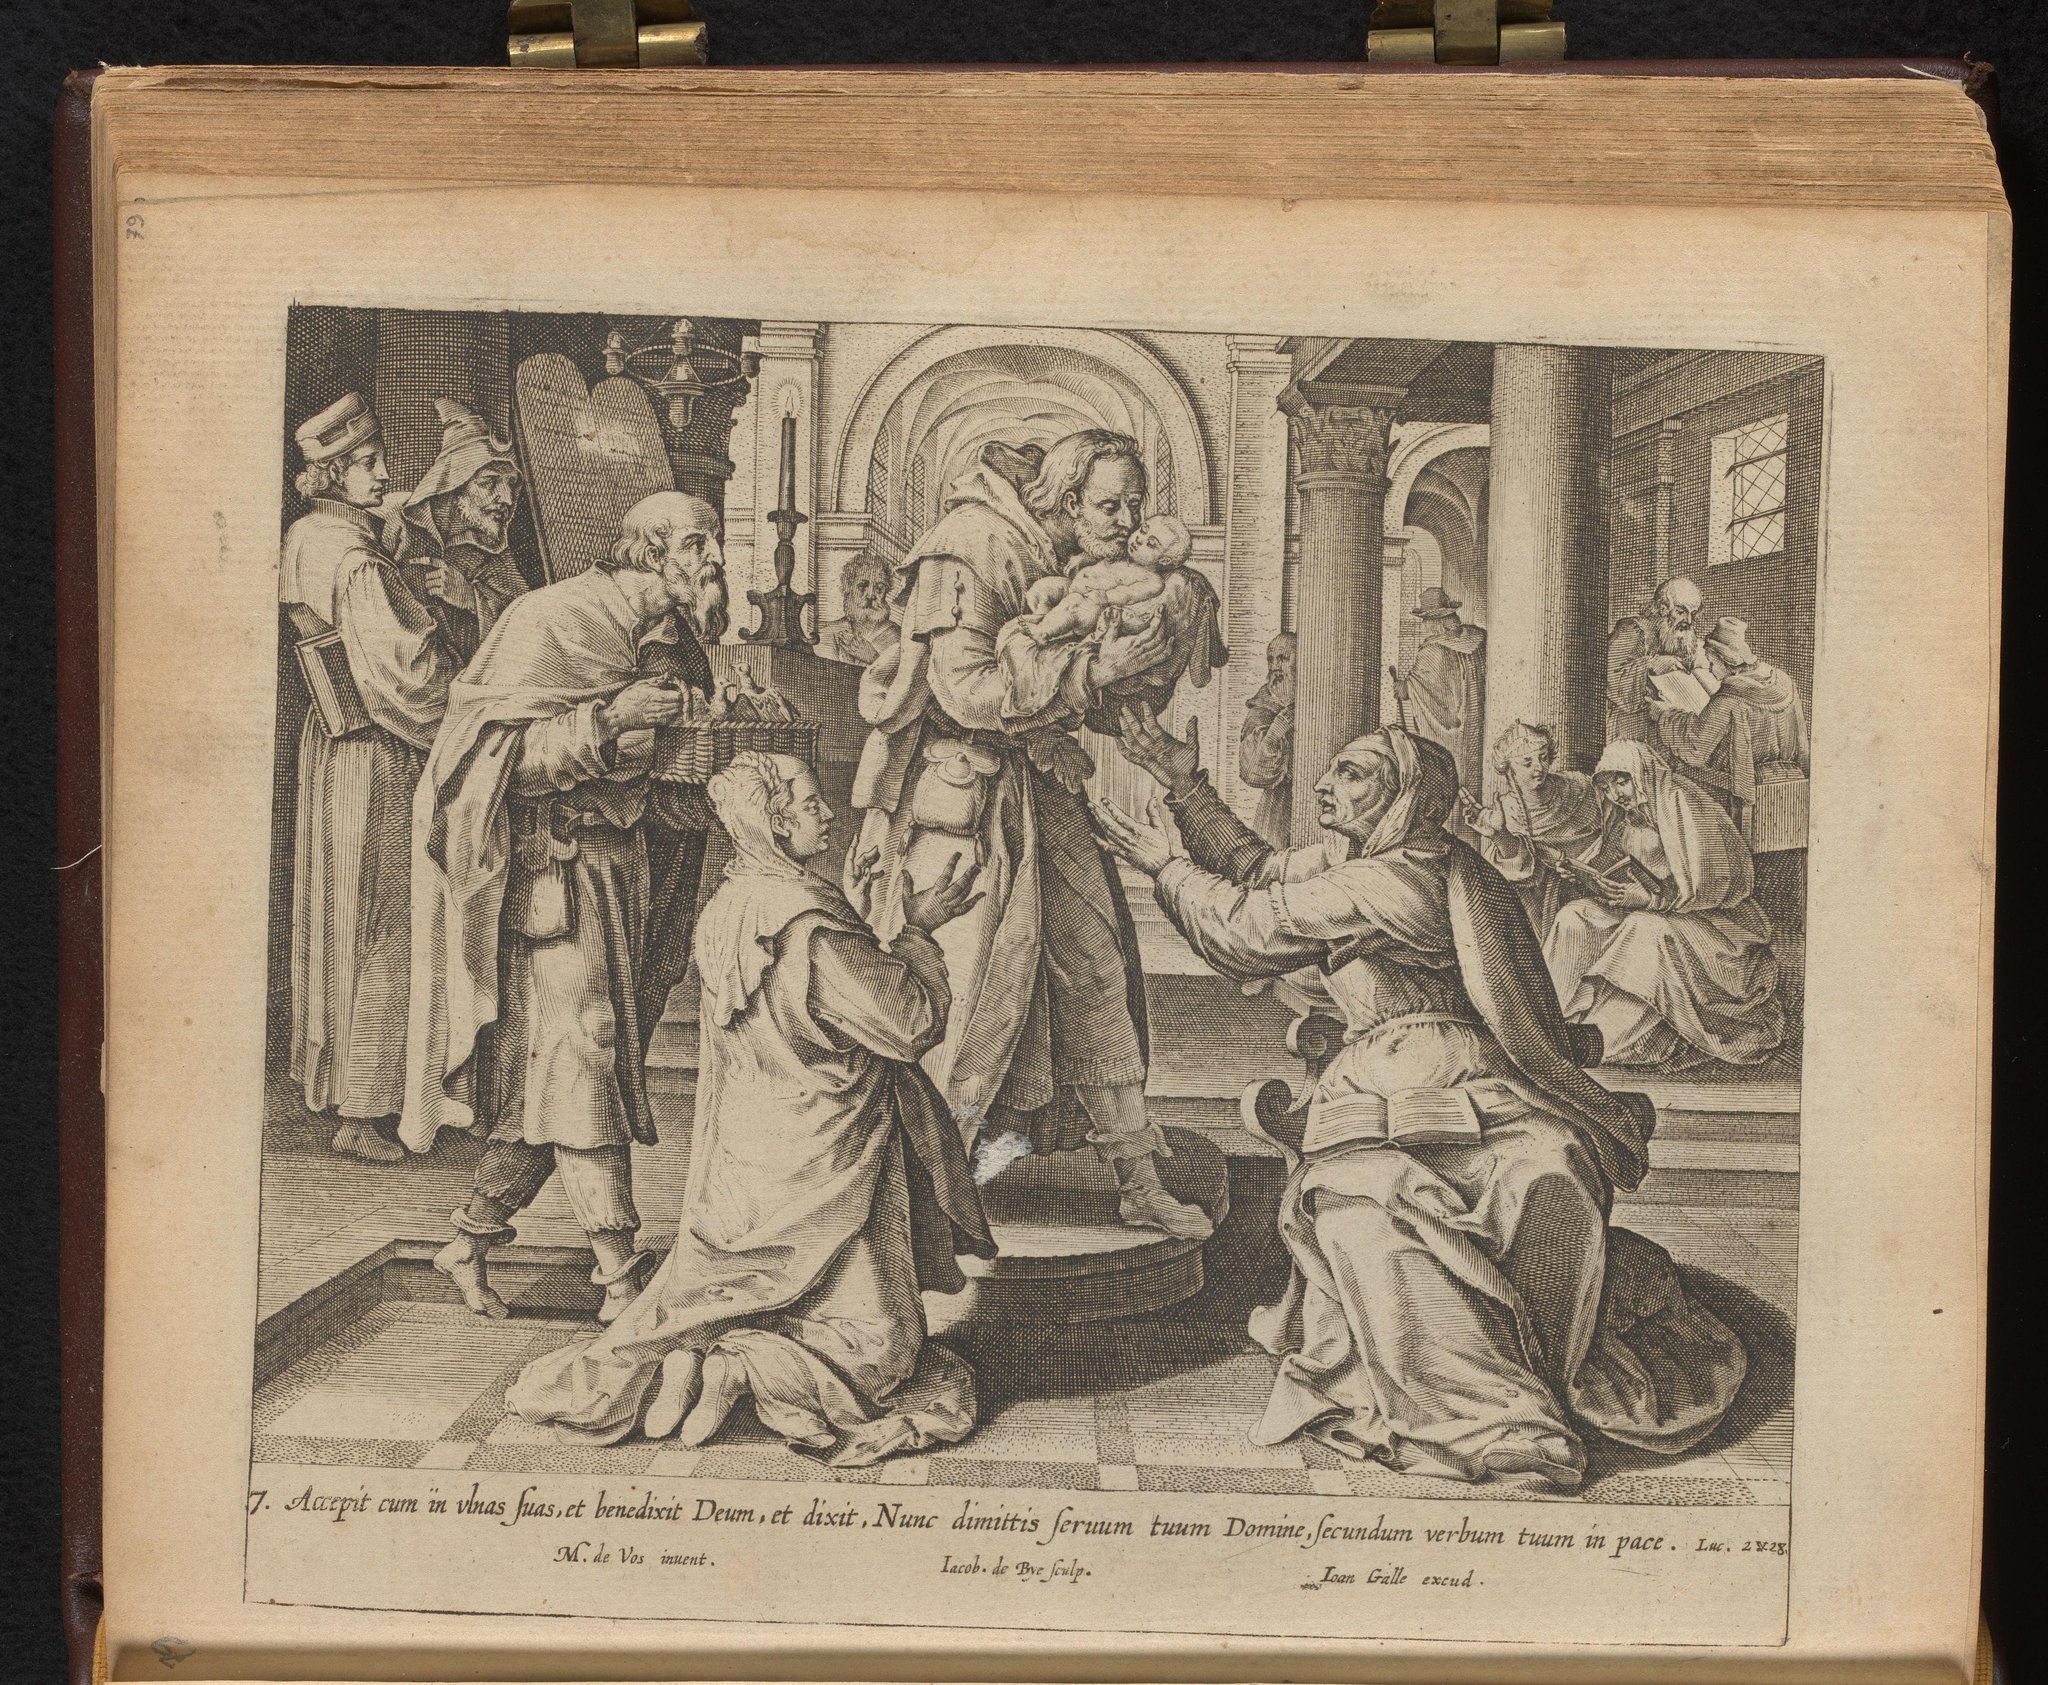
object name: album leaf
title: Presentatie van Christus in de tempel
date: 1598-1618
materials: paper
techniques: engraving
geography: antwerp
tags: presentation of the christ-child in the temple, usually simeon (and anna) present (luke 2:22-39)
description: Prent maakt deel uit van een prentbijbel.